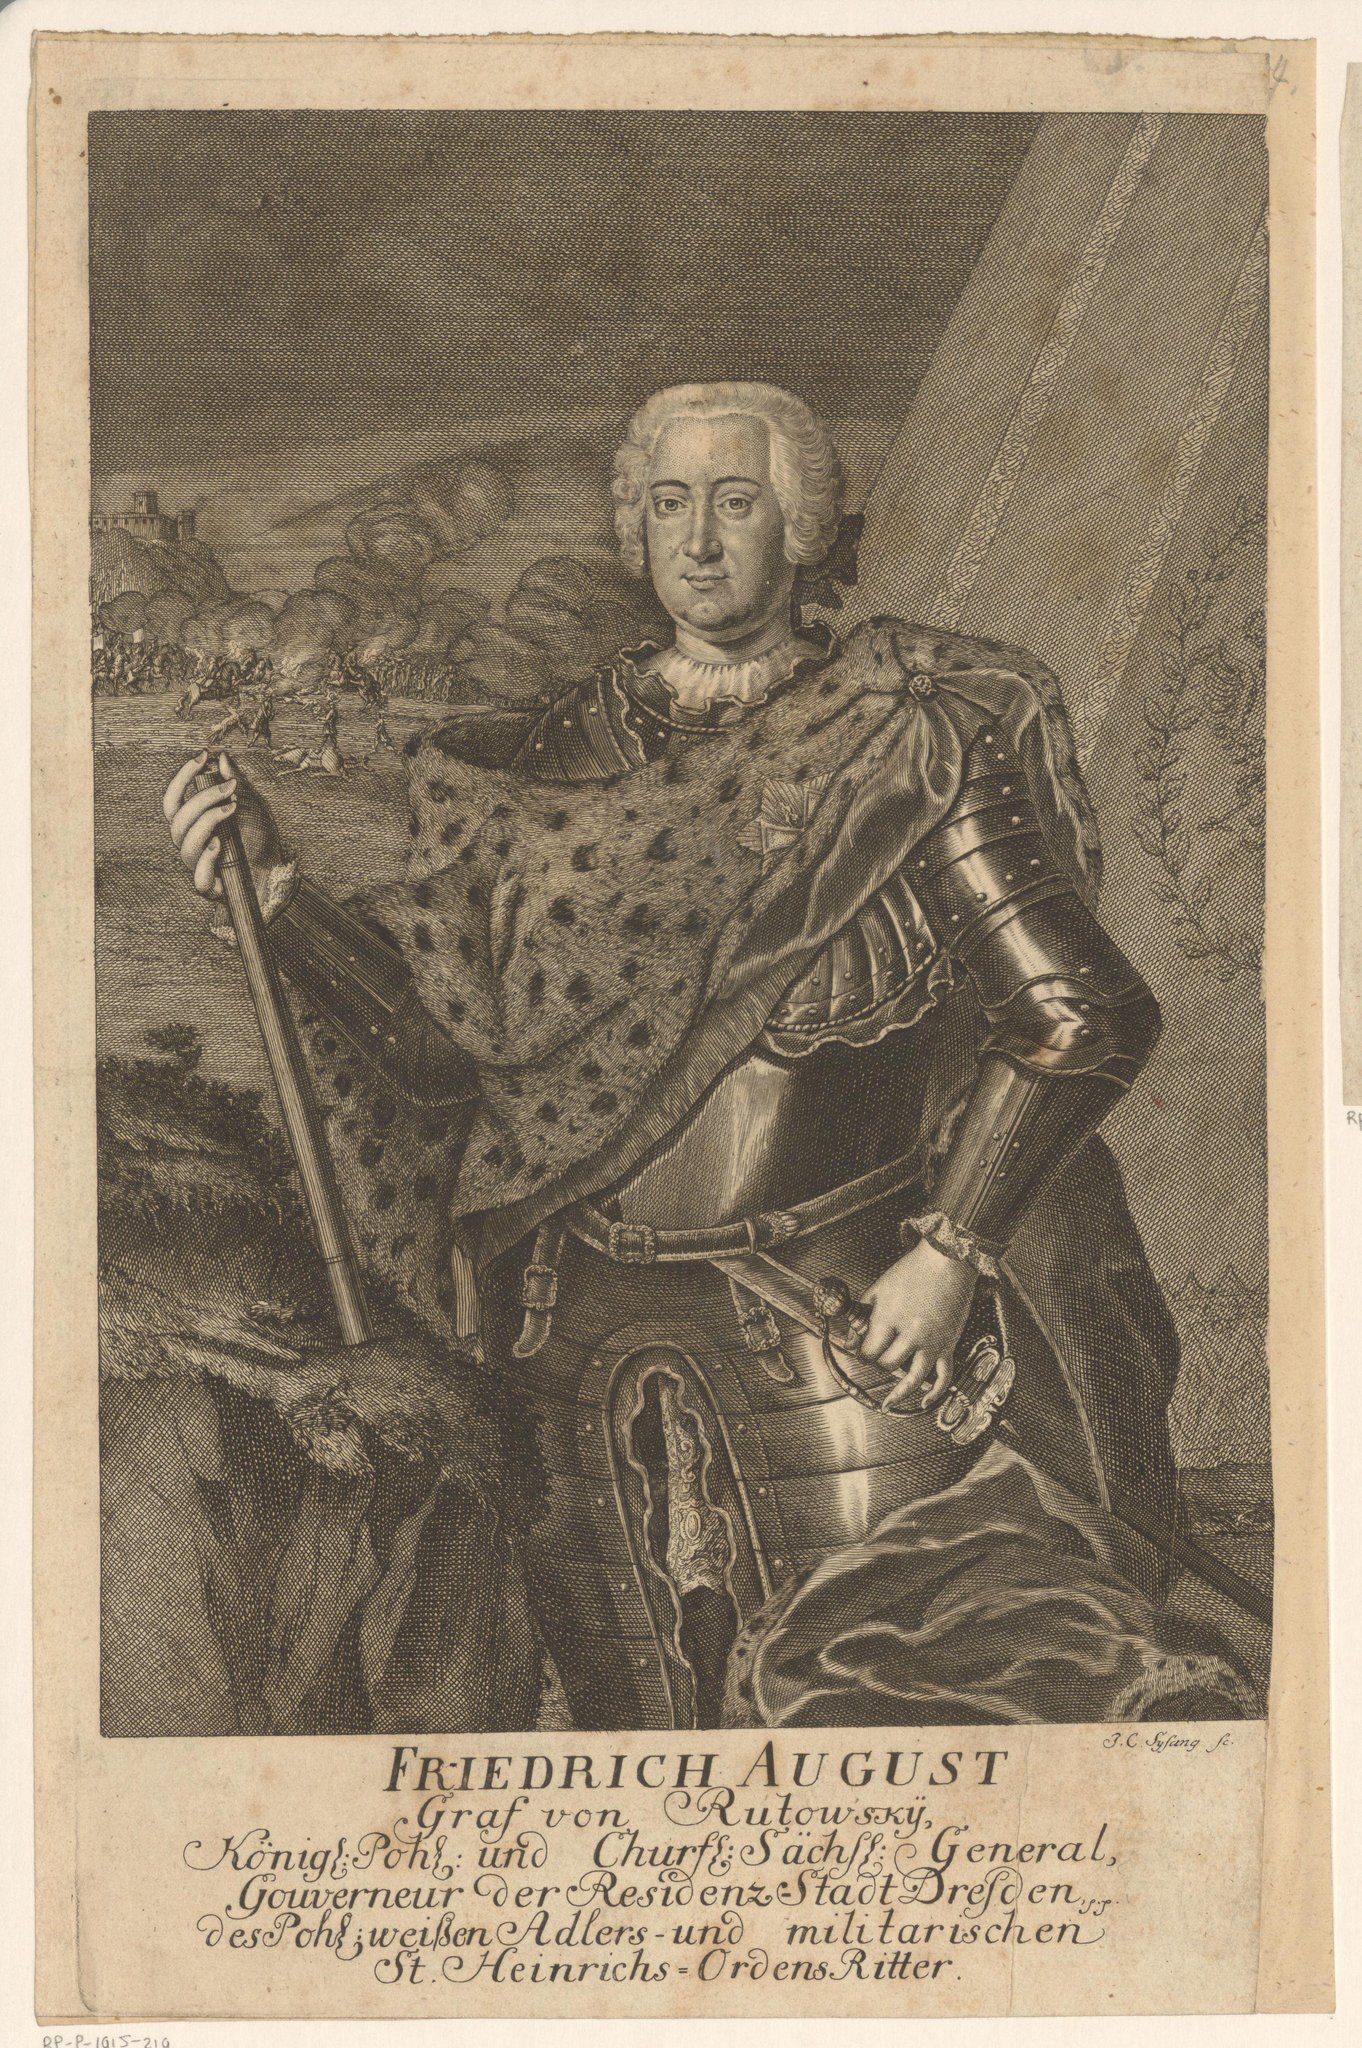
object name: print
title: Portret van Friedrich August, Graf von Rutowski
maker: johann christoph sysang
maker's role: print maker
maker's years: 1703-1757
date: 1740-1757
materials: paper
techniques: engraving, etching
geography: leipzig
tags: armour, historical persons, baton of general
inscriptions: collector's mark: Lugt 2228